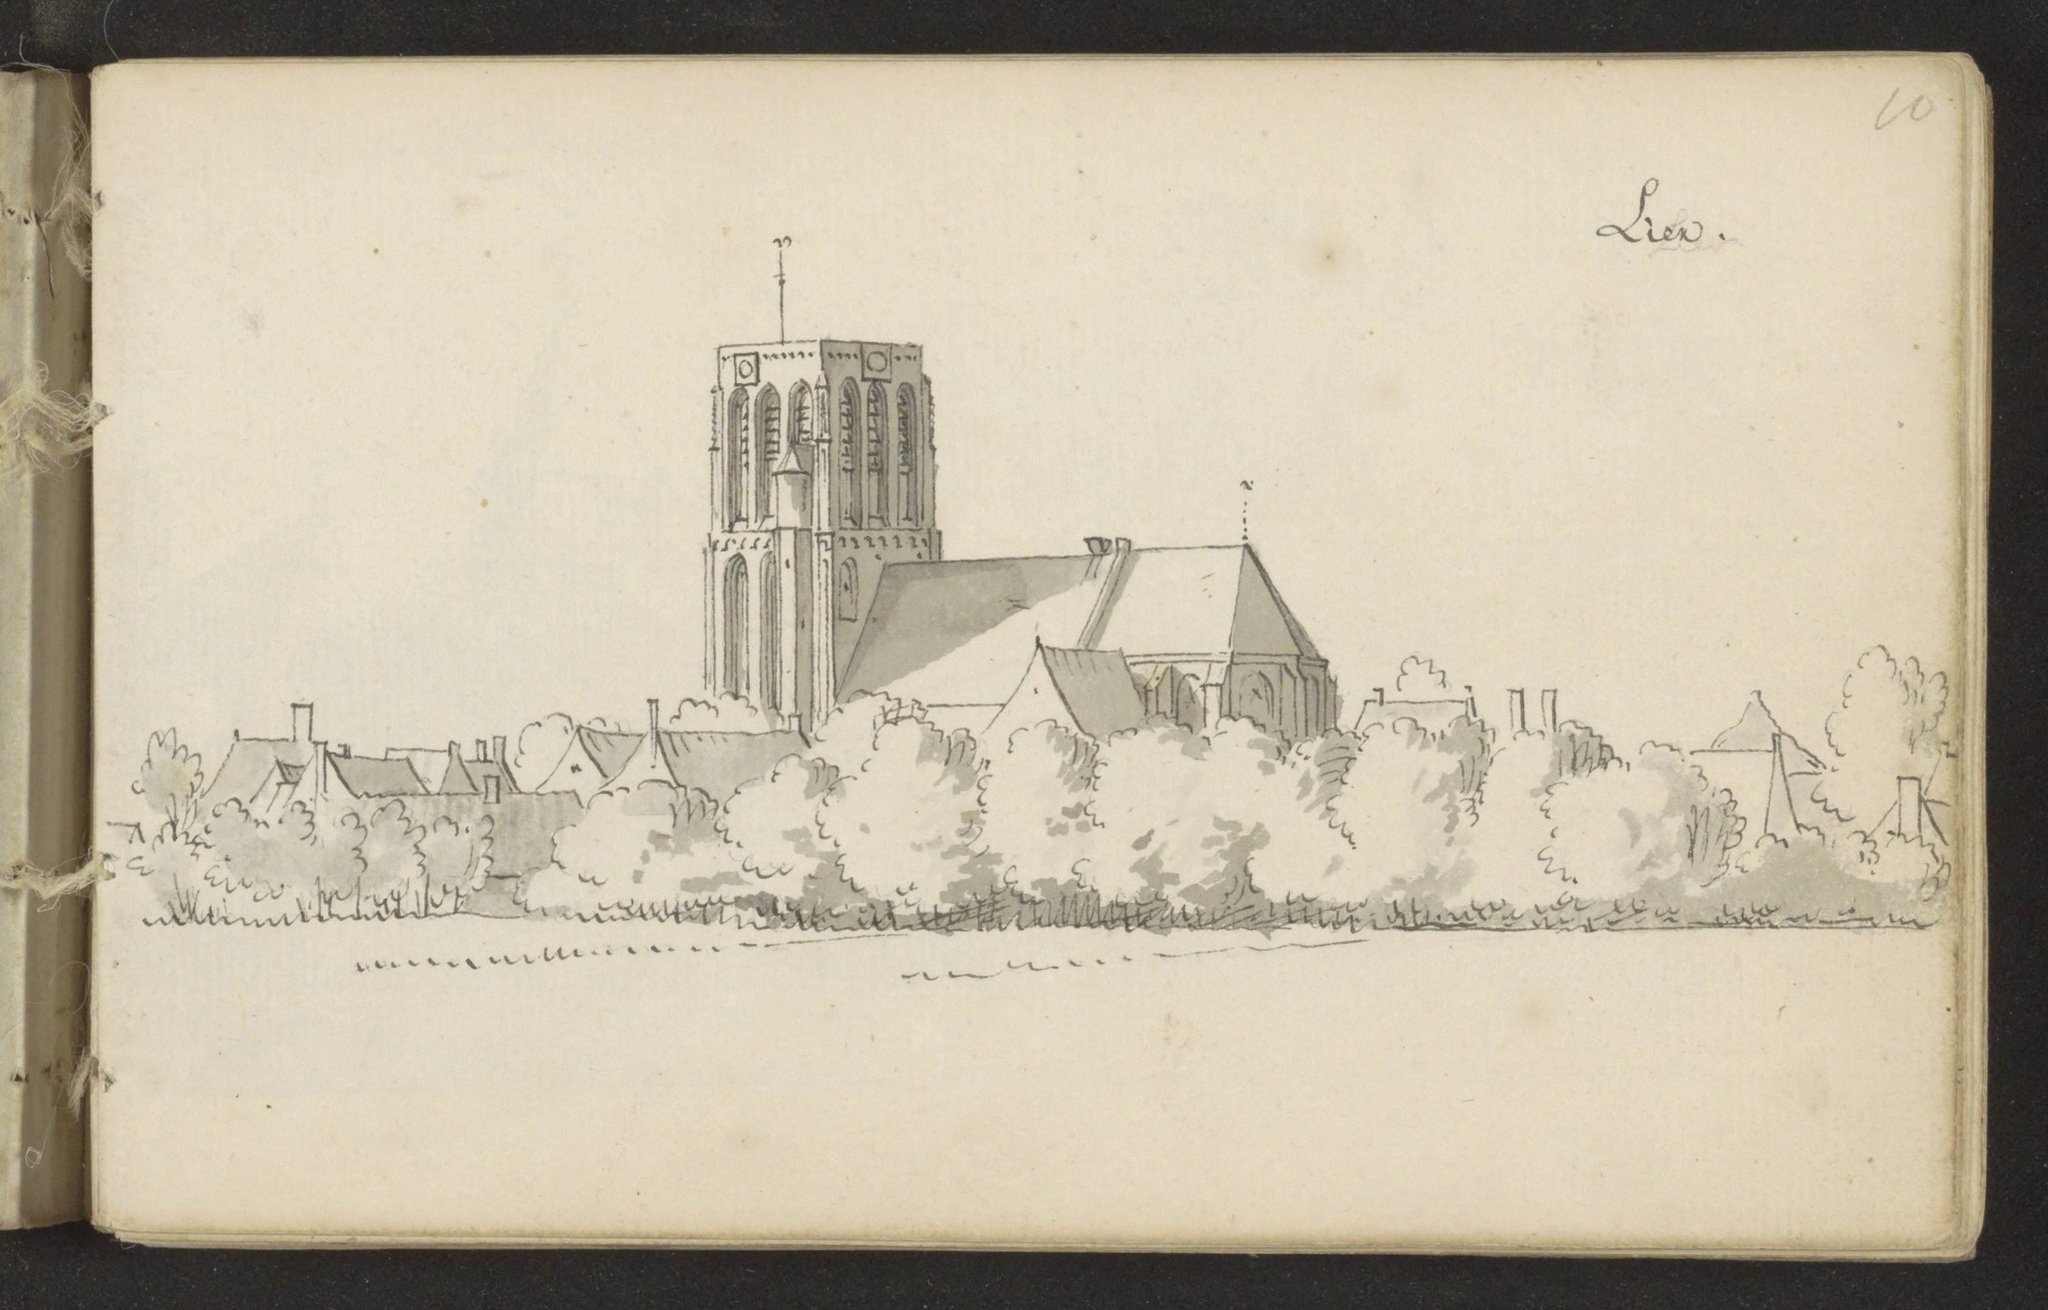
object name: sketchbook leaf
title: Gezicht op De Lier met Domtoren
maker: abraham de haen (ii)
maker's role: draughtsman, print maker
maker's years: 1707-1748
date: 1731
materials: ink, paper, pencil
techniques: brush, pen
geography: de lier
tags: prospect of village, silhouette of village, church (exterior)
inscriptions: annotation: ‘Lier.’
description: Blad 10 recto uit een schetsboek met 78 bladen.